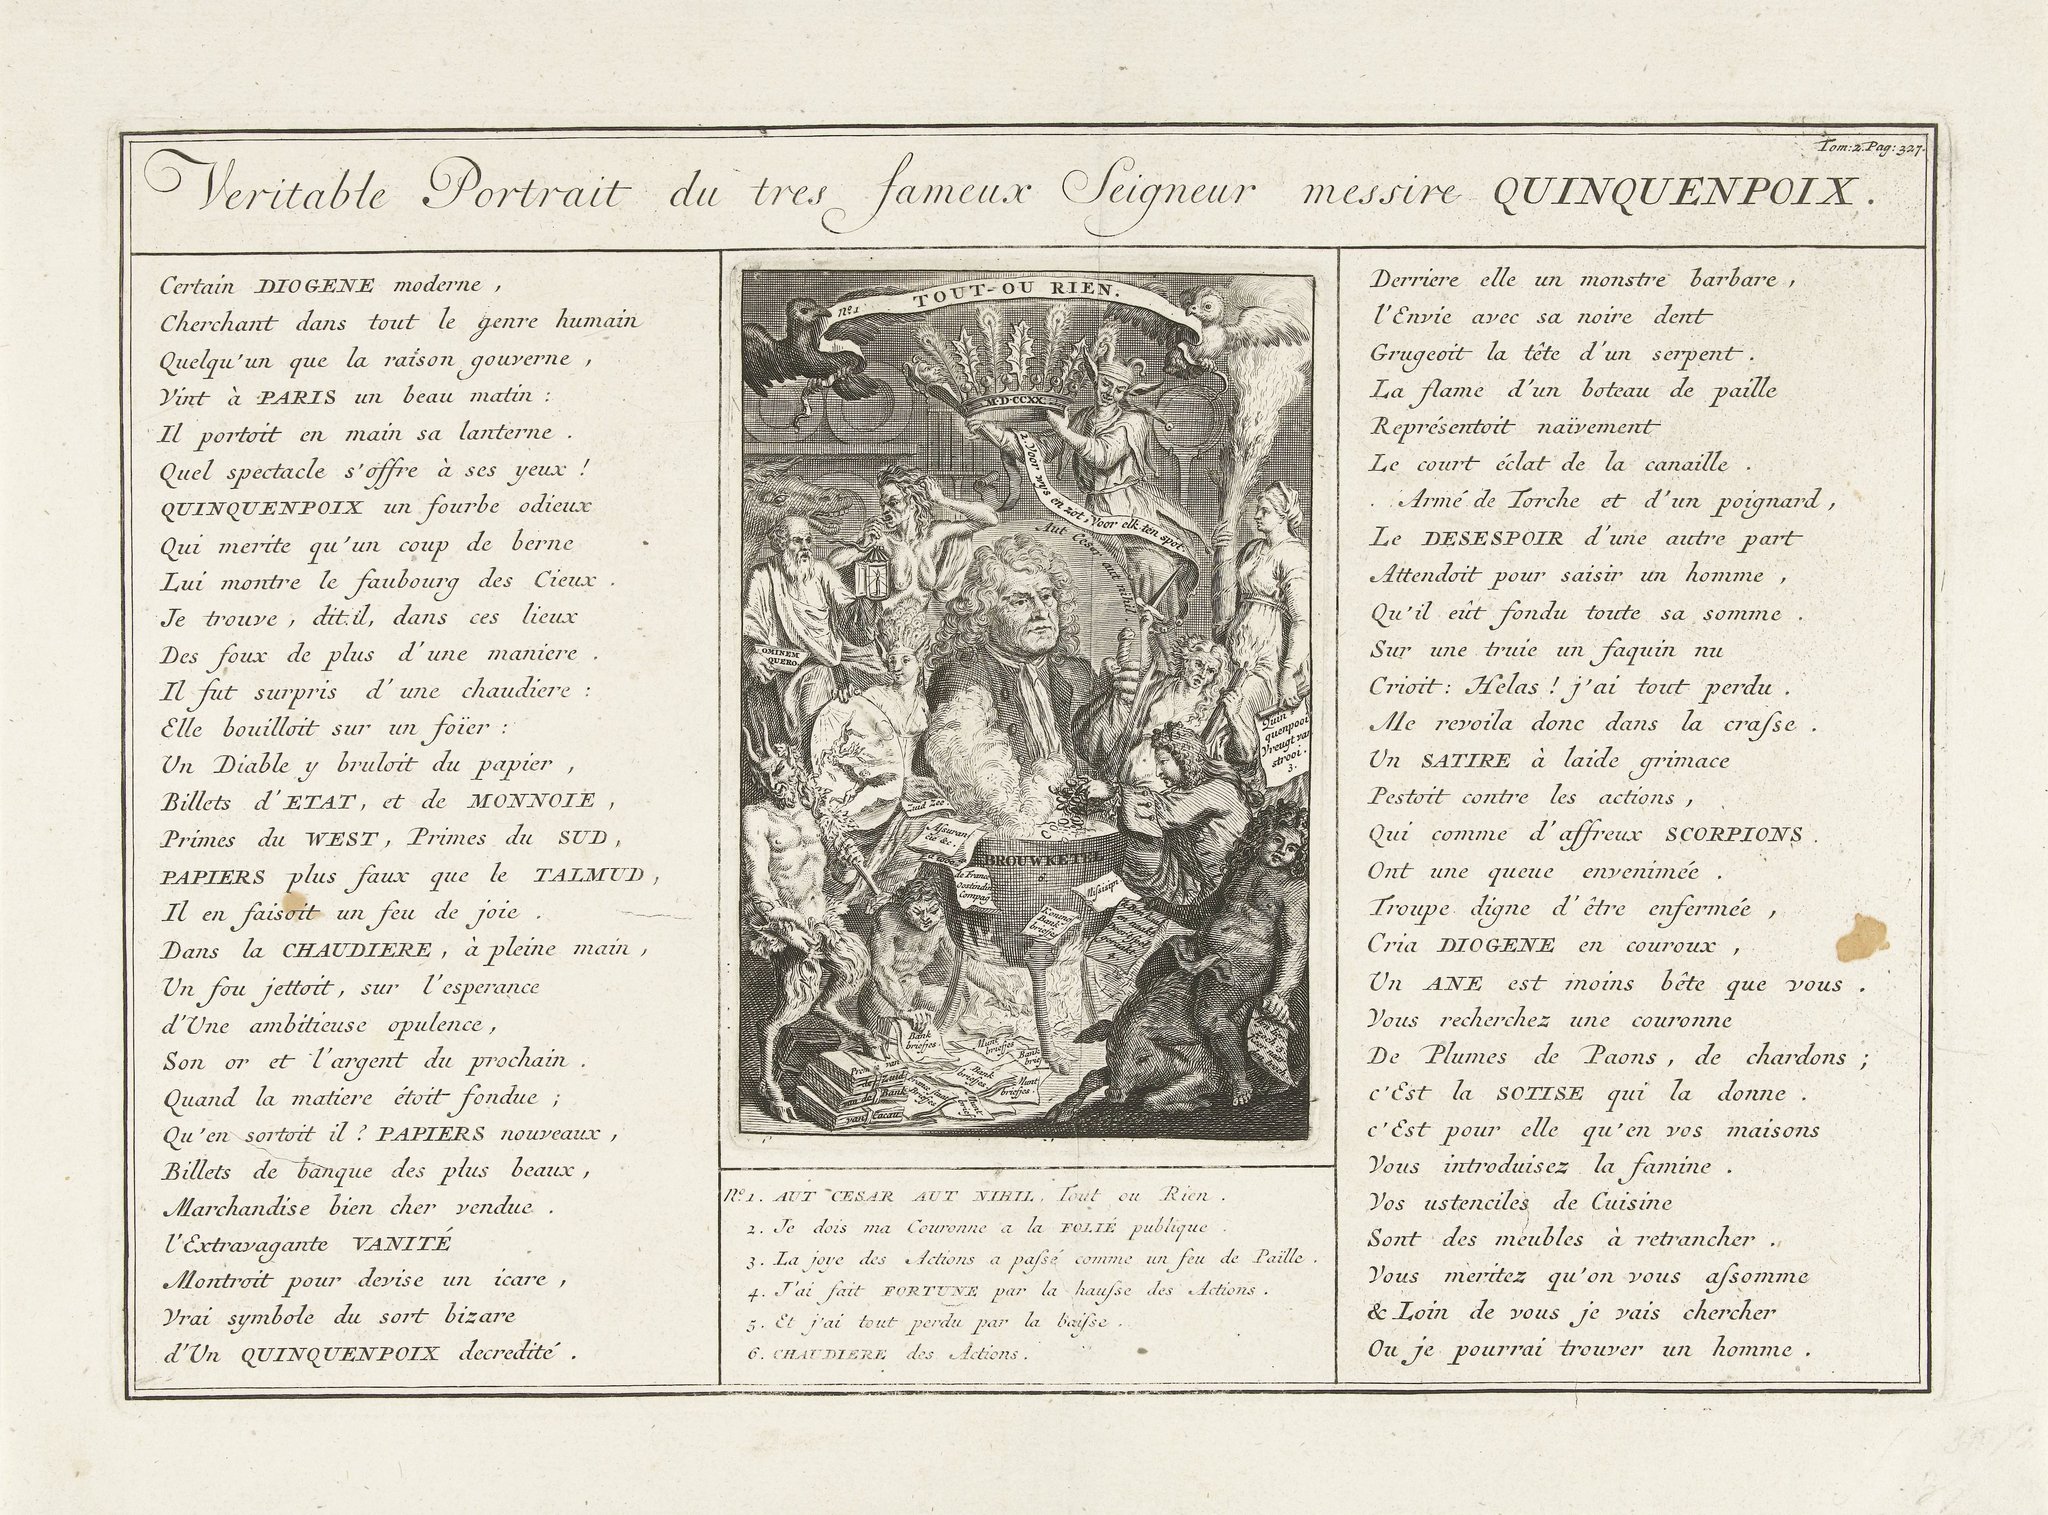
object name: cartoon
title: Veritable Portrait du tres fameux Seigneur messire Quinquenpoix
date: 1712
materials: paper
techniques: engraving, etching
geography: southern netherlands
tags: brewing, boiling (in a cauldron); witches' kitchen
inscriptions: collector's mark: Lugt 2228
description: Ware afbeelding van de heer Quinquempoix. Portretmedaillon van John Law als de heer Quinquempoix boven een brouwketel waarin geldstukken worden omgetoverd tot aandelen. Heksenketel met duivels, uilen etc. Boven het portret de Zotheid met een kroon van pauwenveren en hulstbladeren. Hierboven een banderol met: No. 1 Tout ou Rien. Deze plaat afgedrukt binnen een grotere plaat met titel en verzen in het Frans aan weerszijden. Gemerkt rechtsboven: Tom: 2. Pag: 327. Prent 37 in de serie Het Groote Tafereel der Dwaasheid met spotprenten op de Windhandel of Actiehandel van 1720.